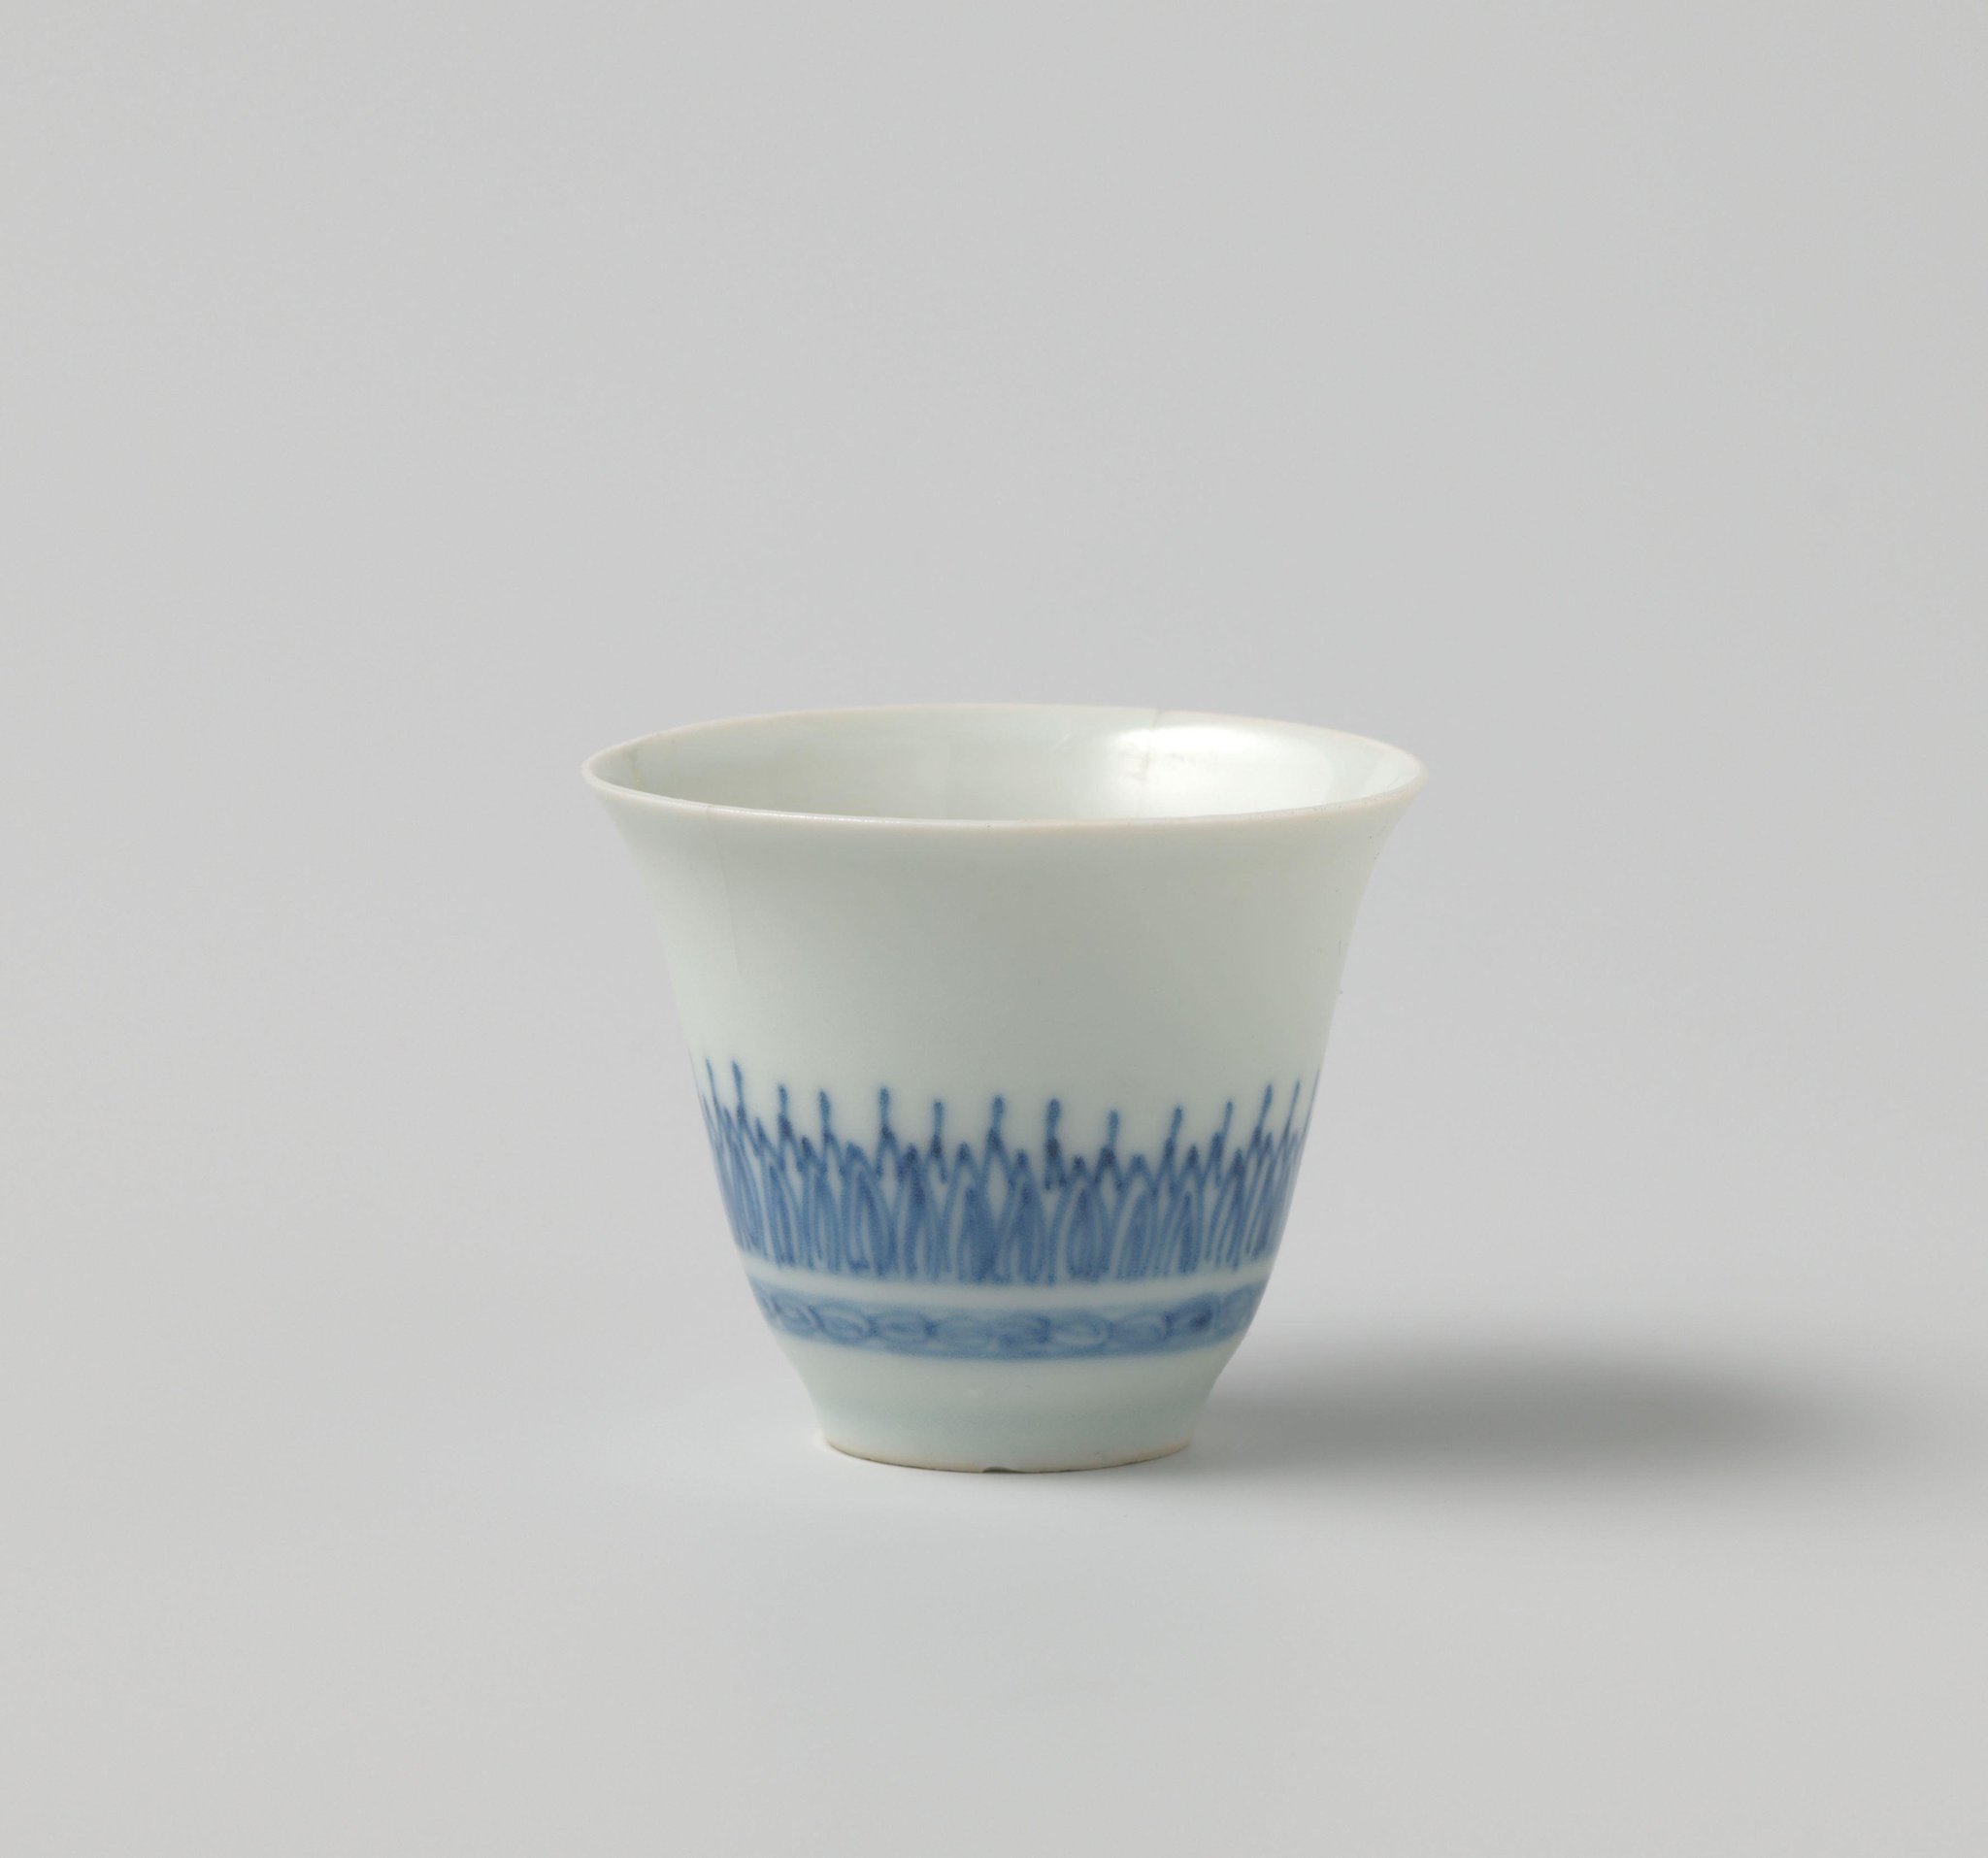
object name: wine cup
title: Wijnkop uit V.O.C.-schip de 'Witte Leeuw'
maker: Anonymous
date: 1613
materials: porcelain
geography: jingdezhen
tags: verenigde oostindische compagnie, sint-helena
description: Wijnkop uit V.O.C.-schip de 'Witte Leeuw', compleet. De scherf is glasachtig en wit en kent geen ingebakken vuil. Het glazuur is blauw getint en heeft pinholes en kleine bakscheurtjes aan de binnenzijde. De voetring staat naar binnen en is recht.